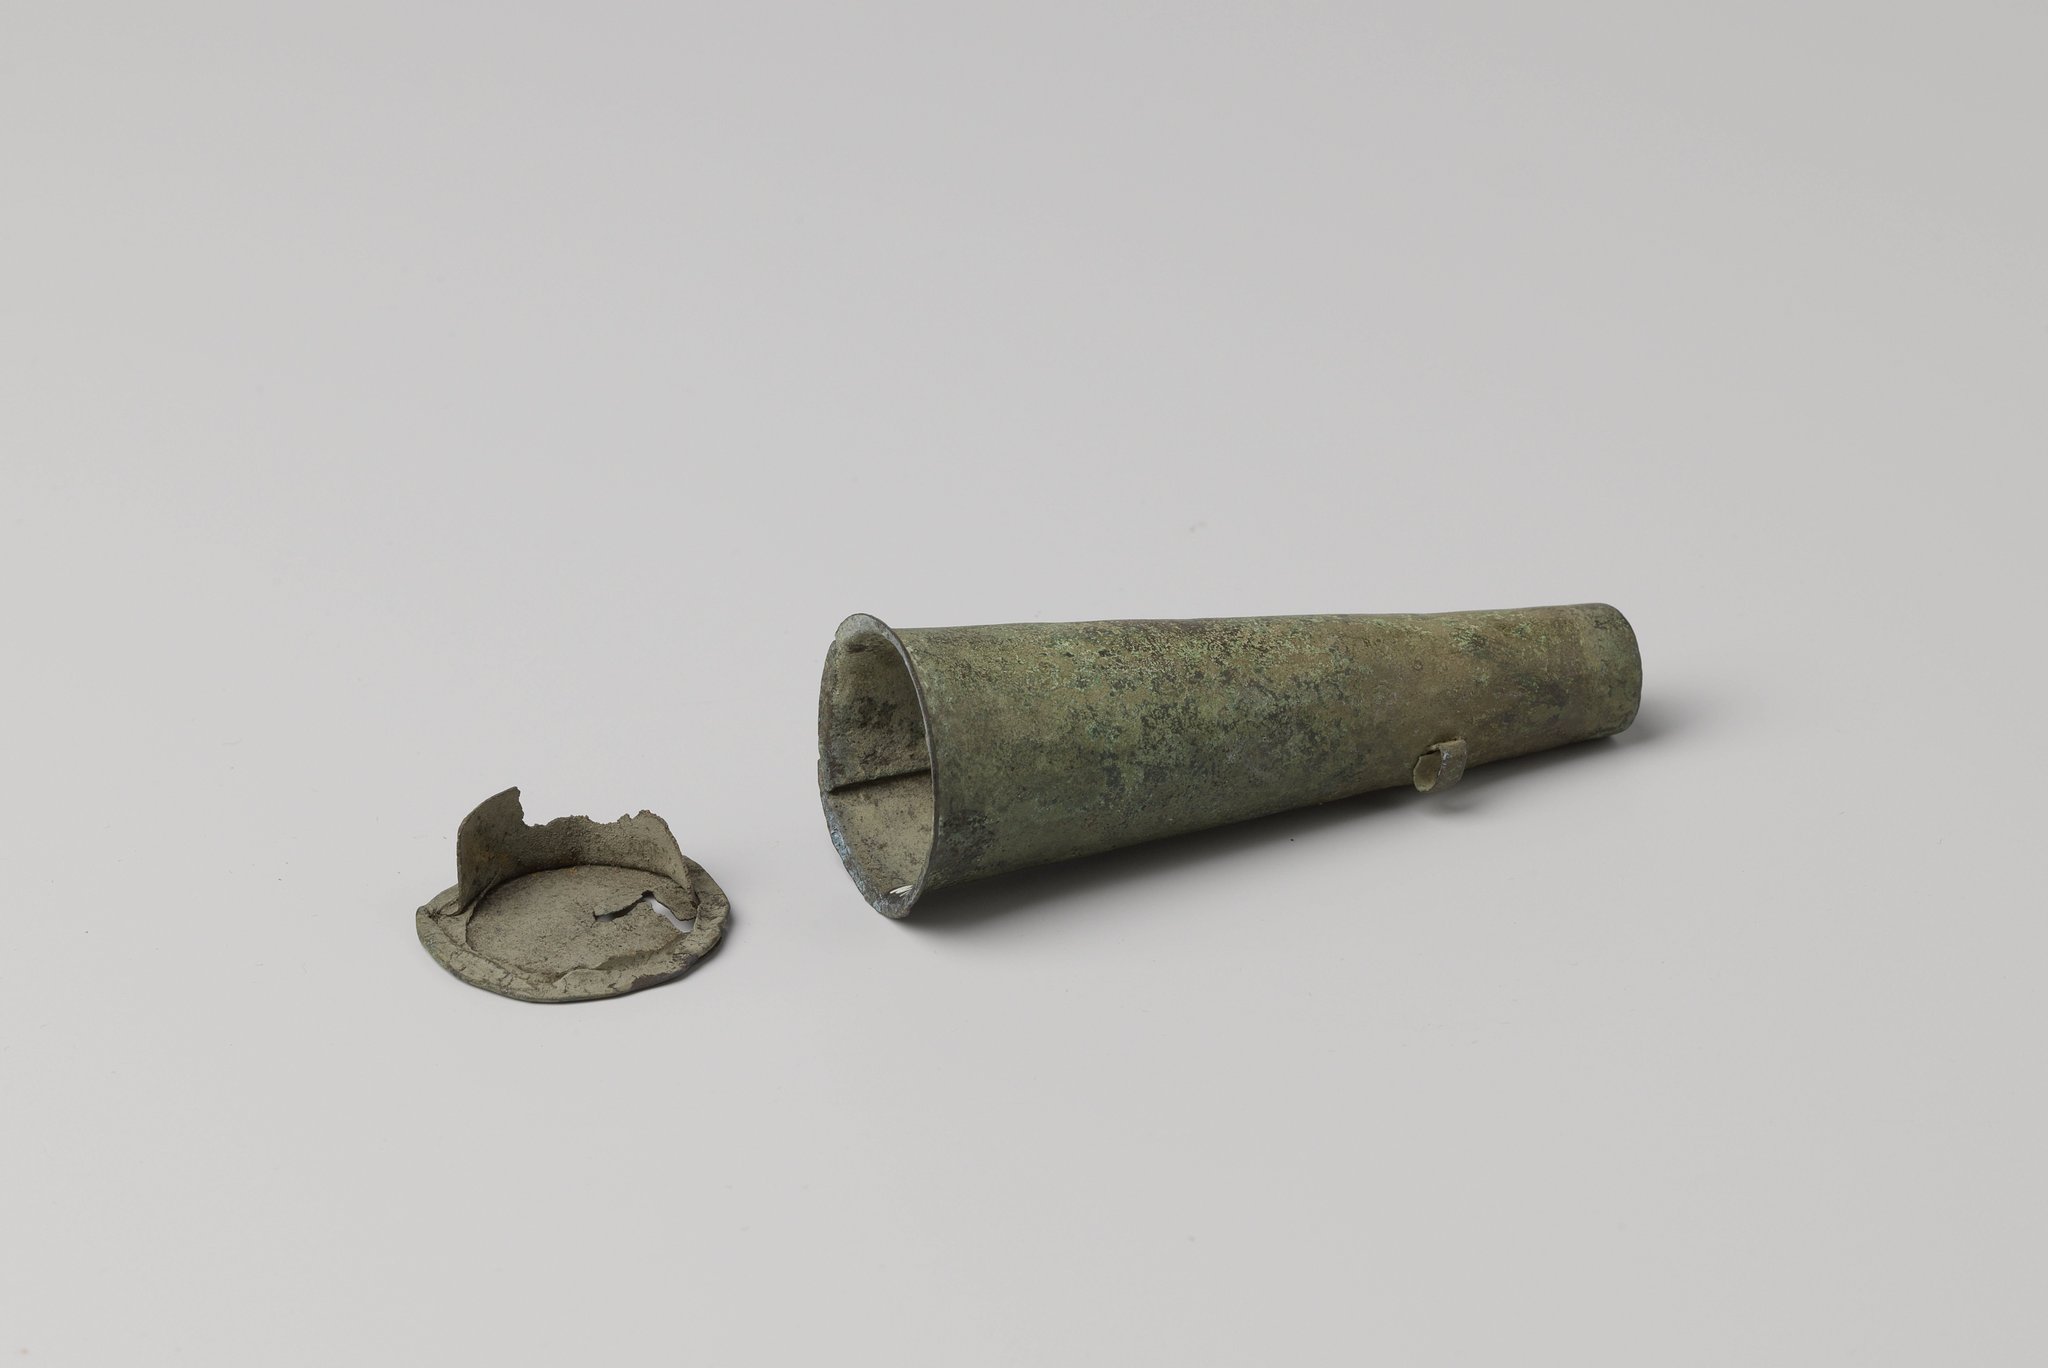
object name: kruitmaat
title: Fragment van musketmaat voor musketbandelier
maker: Anonymous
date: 1590-1596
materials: brass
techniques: striking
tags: willem barendsz., amsterdam, jacob van heemskerck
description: Musketmaat voor musketbandelier, fragment bestaande uit messing huls en één oortje. Lederen bekleding ontbreekt. Standaardbeschrijving musketmaat: messing met leder bekleed. Voorzien van twee oogjes aan de zijkant om een koord door te doen waarmee de deksel werd vastgehouden en het maatje aan de bandelier werd gehangen. Een muskettiersbandelier had twaalf kruitmaatjes en een zakje met kogels. De kruitmaatjes bevatten een zorgvuldig afgepaste hoeveelheid buskruit voor één schot.